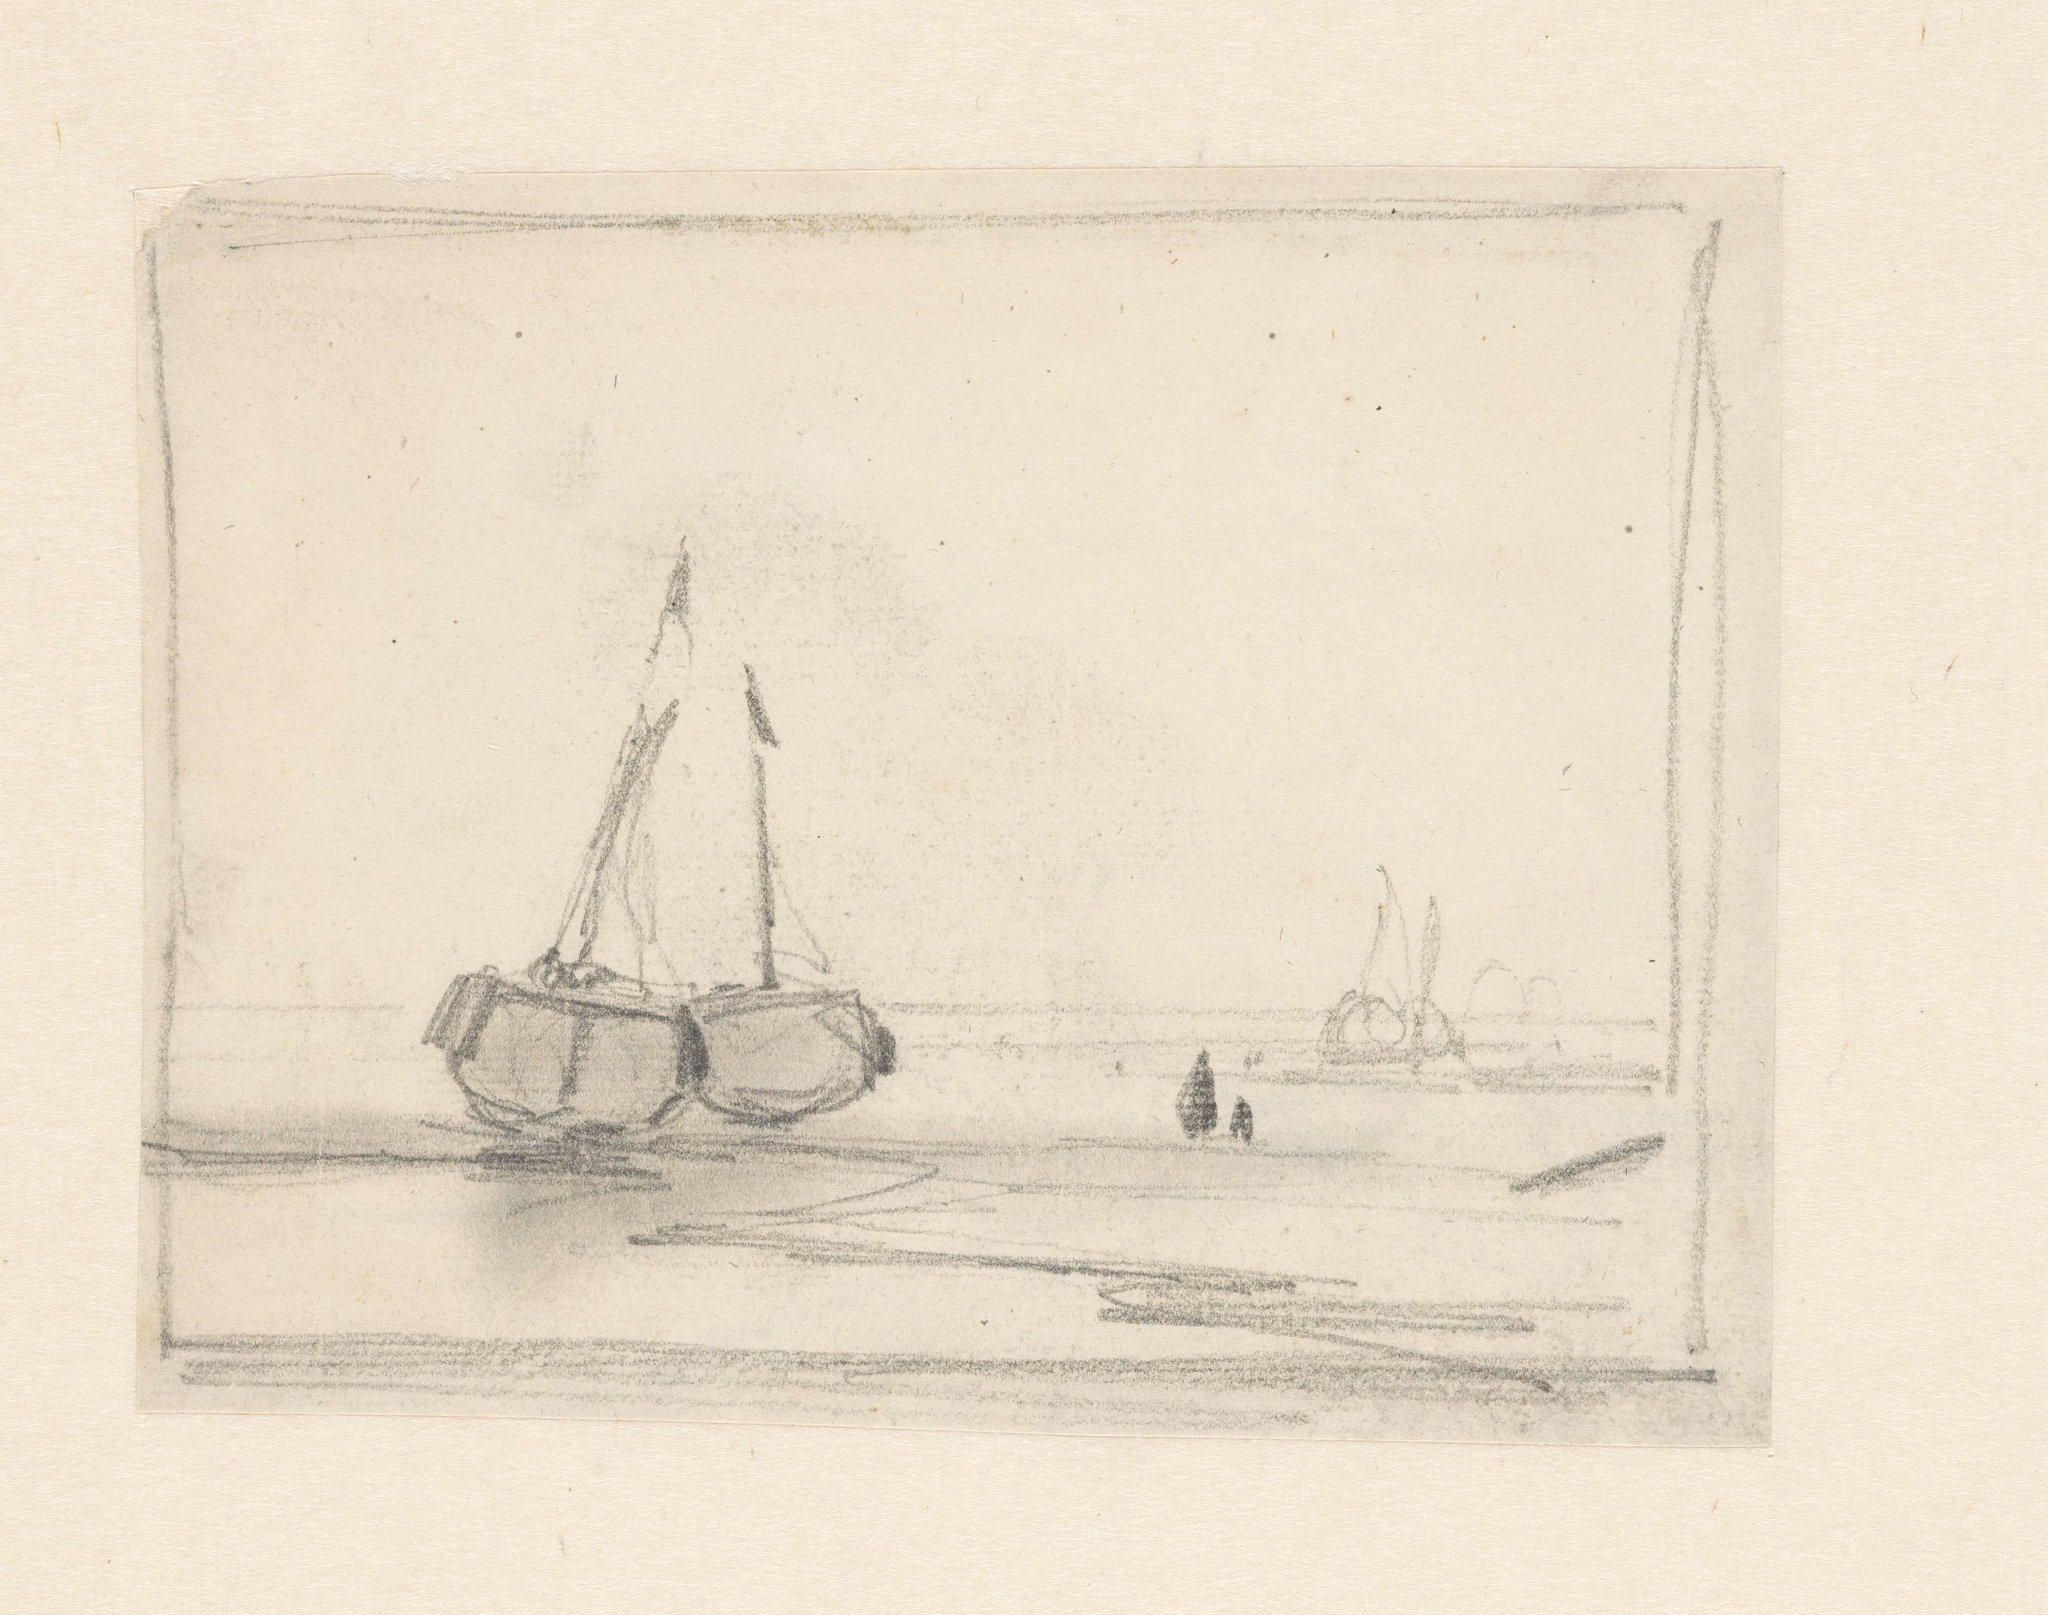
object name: drawing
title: Schets van vissersschepen op het strand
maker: andreas schelfhout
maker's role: draughtsman, painter, print maker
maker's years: 1787-1870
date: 1797-1870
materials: paper, pencil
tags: commercial fishery, ships (in general), beach